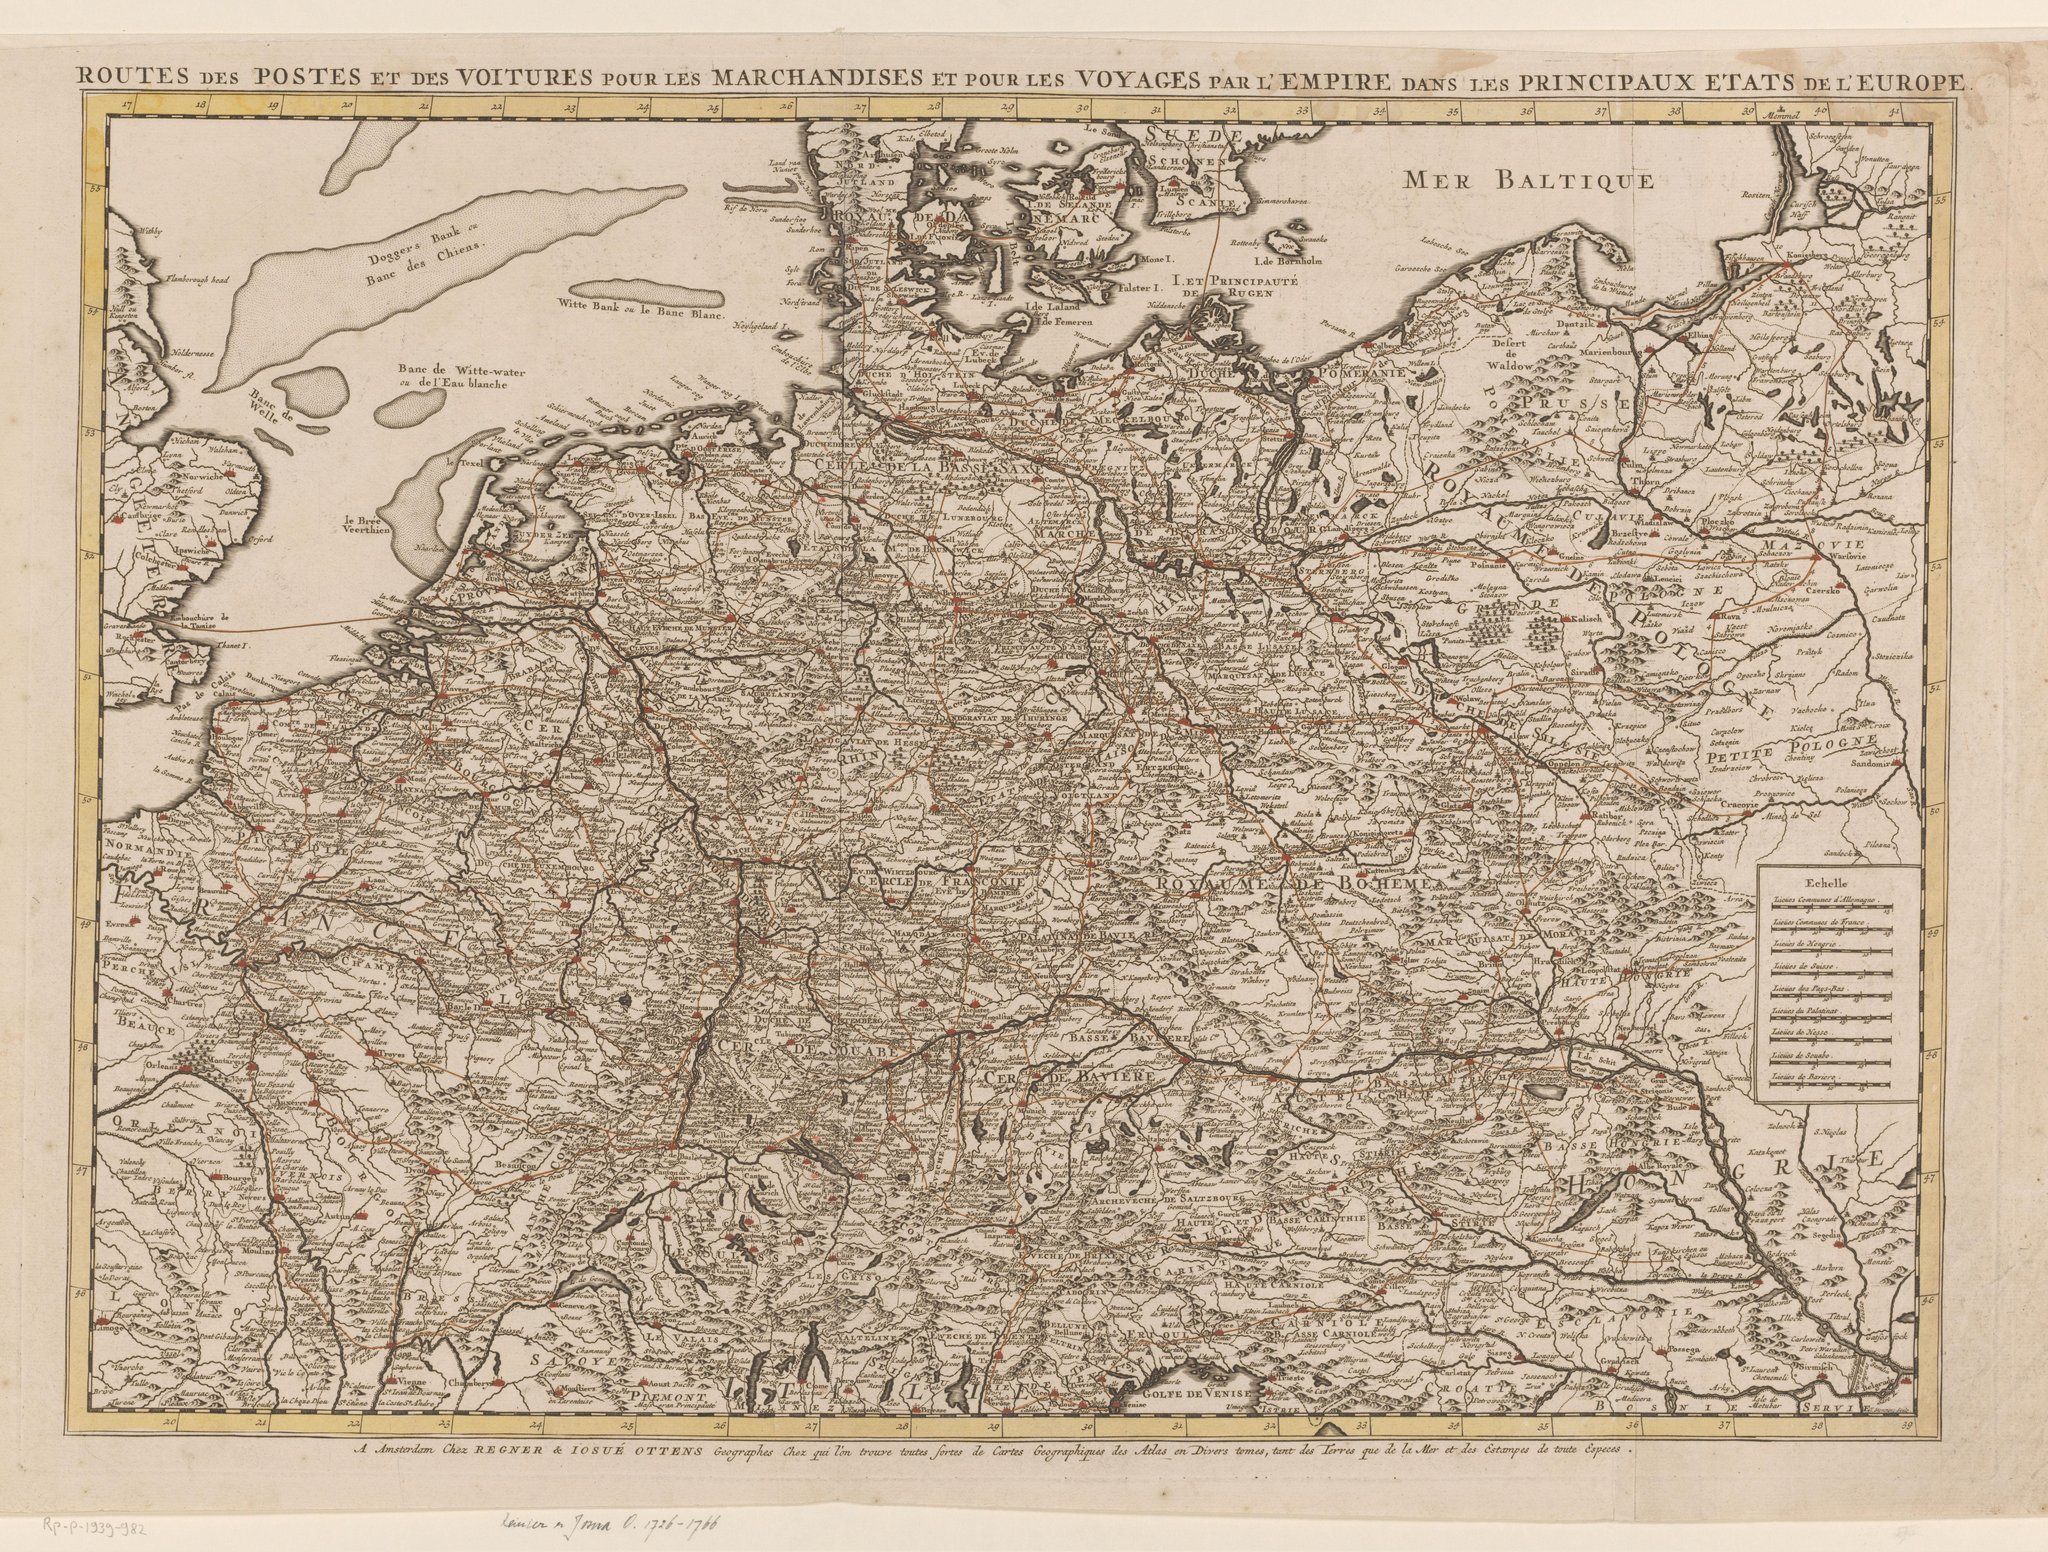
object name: print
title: Kaart van Nederland, Duitsland, België en Denemarken waarop de postroutes zijn aangegeven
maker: jan stemmers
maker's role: print maker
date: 1726-1750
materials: paper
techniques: engraving, hand coloring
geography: amsterdam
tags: postal service, maps, atlases, netherlands, germany, denmark, belgium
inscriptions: collector's mark: Lugt 2760, collector's mark: Lugt 2228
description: Prent ook gebruikt in: Atlas maior cum generales omnium totius orbis regnorum. 8 delen. Amsterdam: Reinier en Joshua Ottens, 1734-1746.